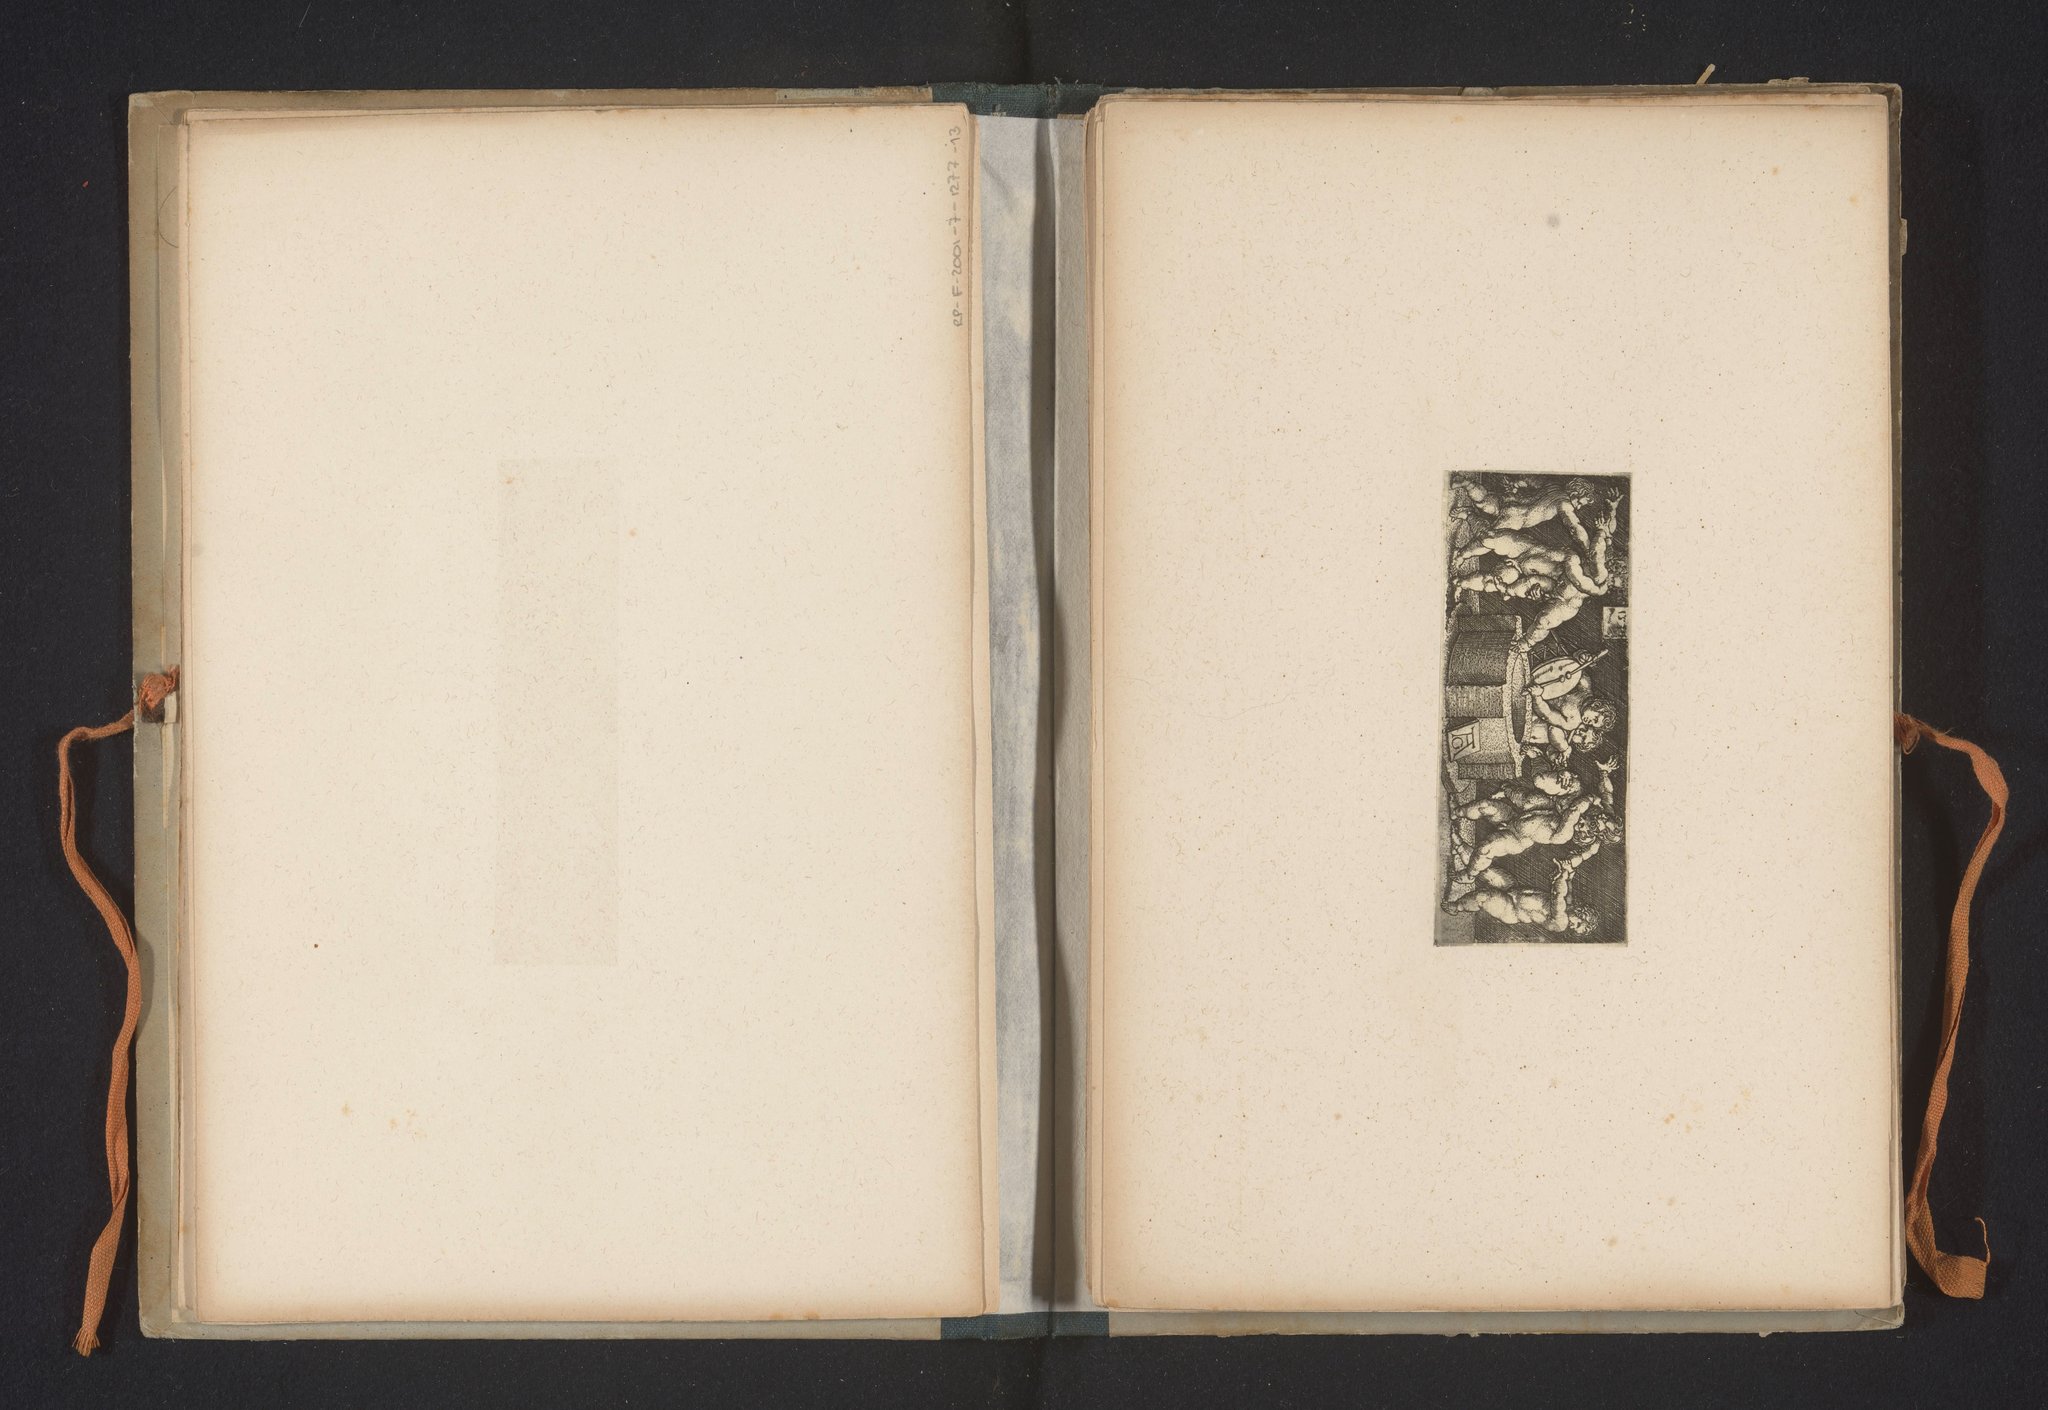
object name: reproduction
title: Reproductie van een prent van cupido's rond een put, door Heinrich Aldegrever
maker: heinrich aldegrever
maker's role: draughtsman, print maker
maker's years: 1502-1561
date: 1866-1871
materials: paper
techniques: woodburytype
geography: brussels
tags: well, cupids: 'amores', 'amoretti', 'putti'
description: Deze prent maakt deel uit van een omslag met 57 prenten op 54 bladen.